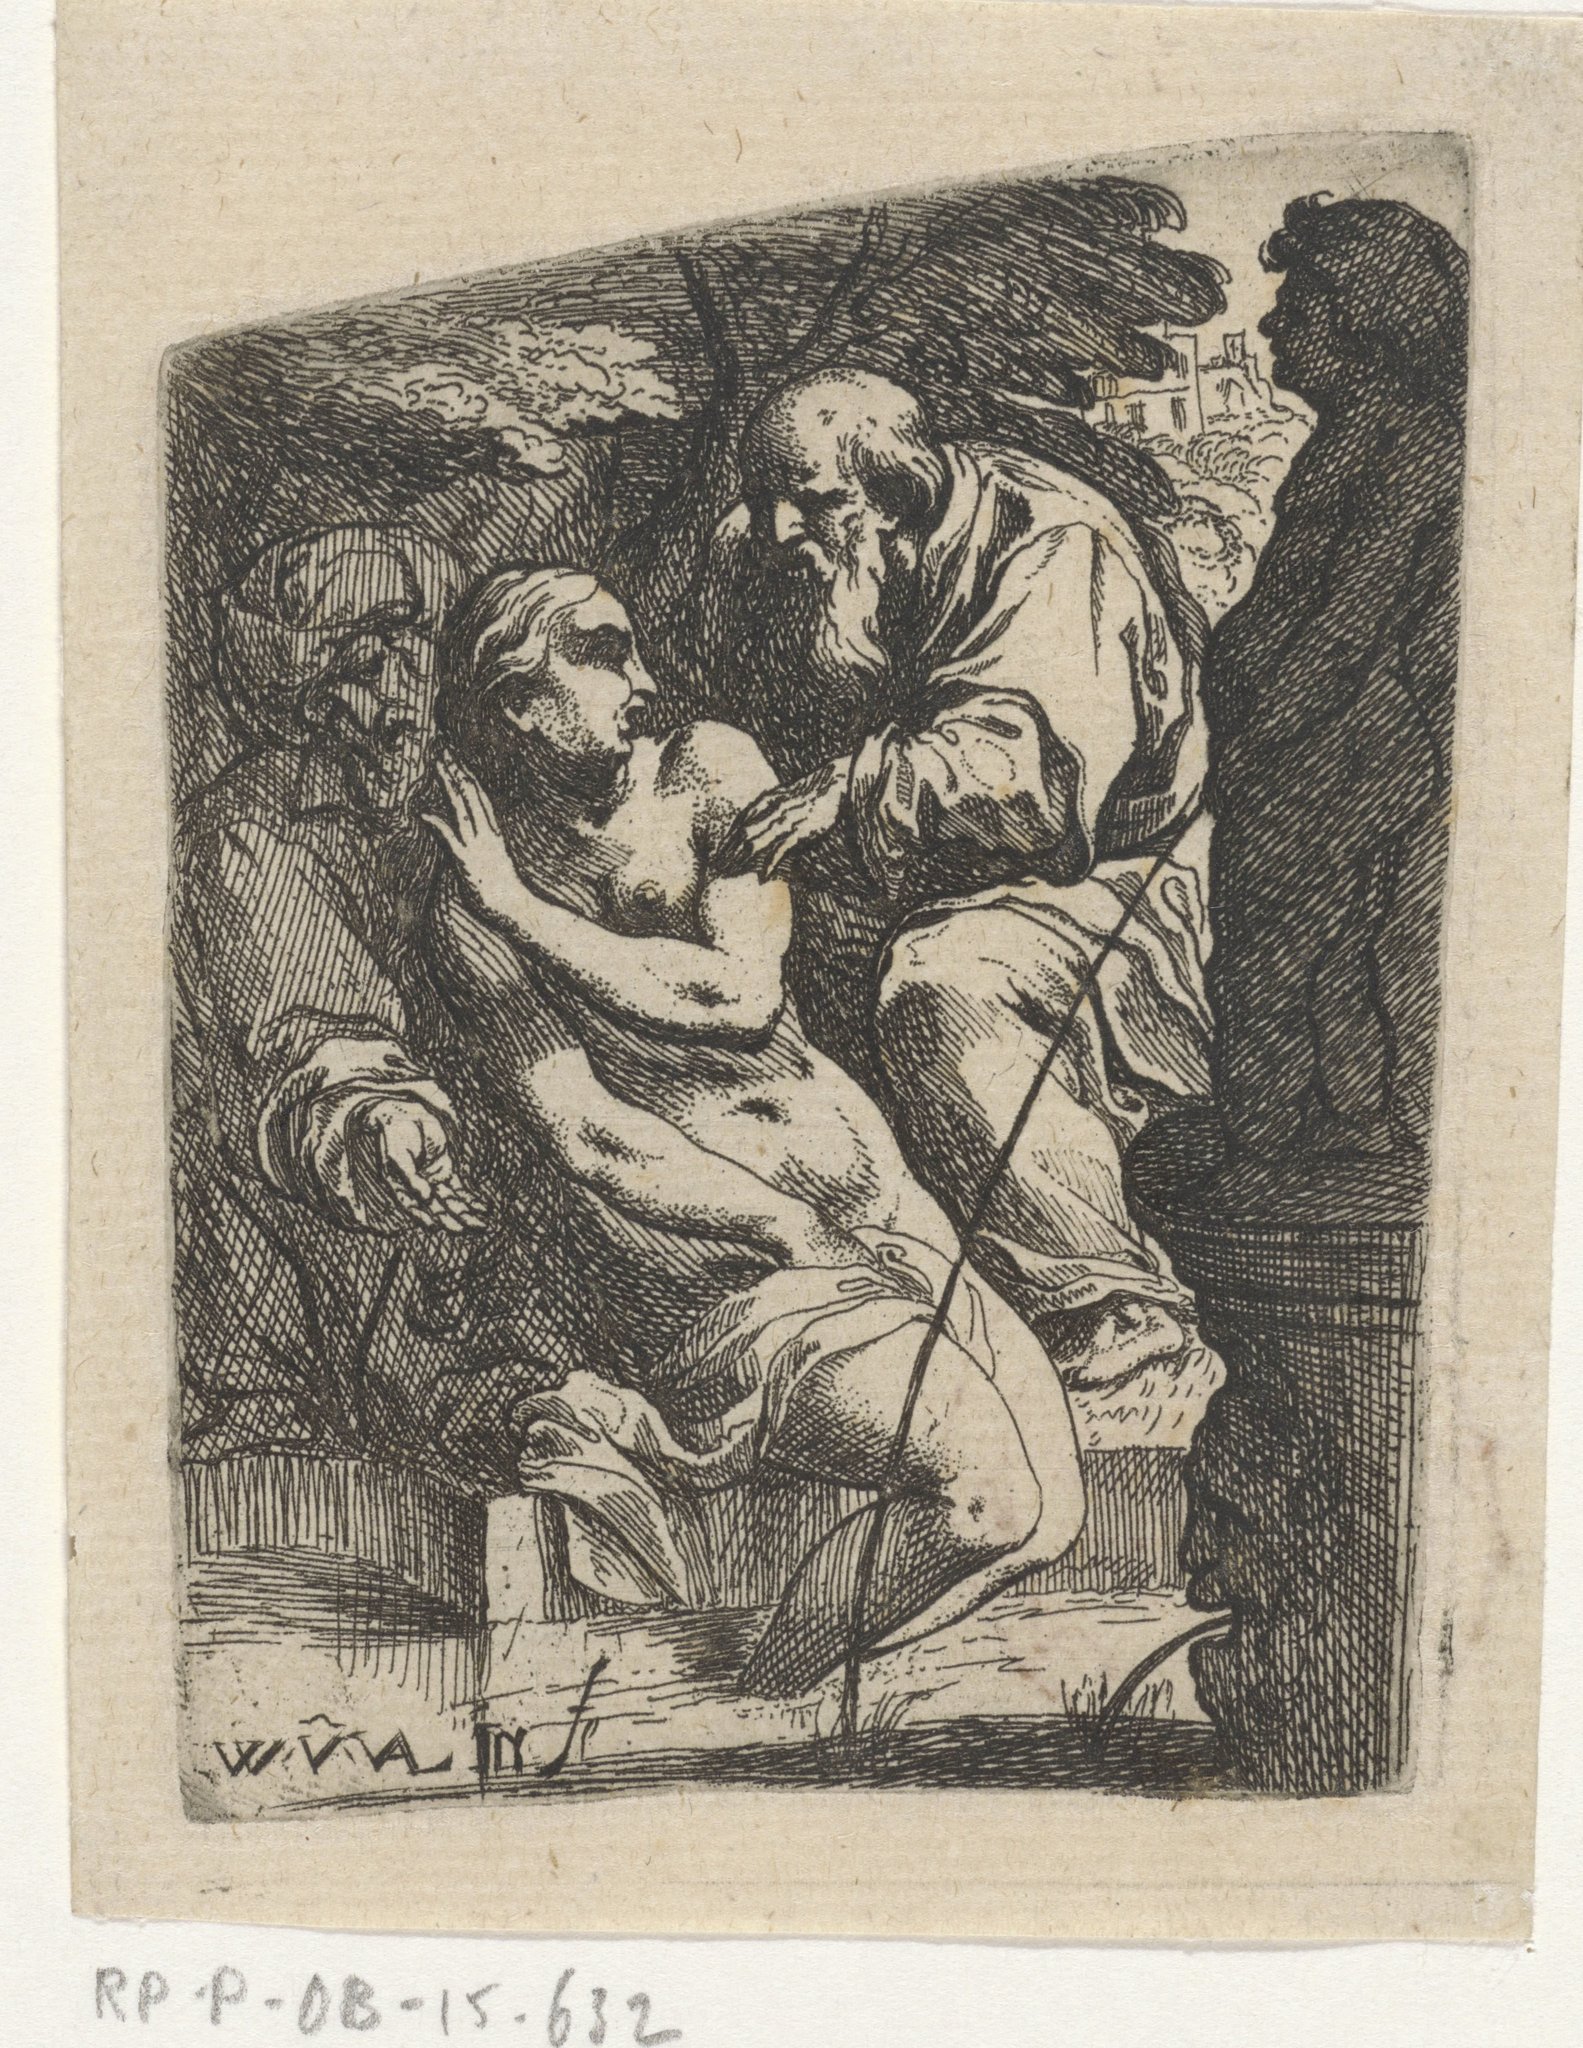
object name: print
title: Suzanna en de ouderlingen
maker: werner van den valckert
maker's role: draughtsman, painter, print maker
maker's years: 1580-1627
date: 1595-1645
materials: paper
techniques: etching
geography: northern netherlands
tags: the elders making advances towards susanna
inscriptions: collector's mark: Lugt 240